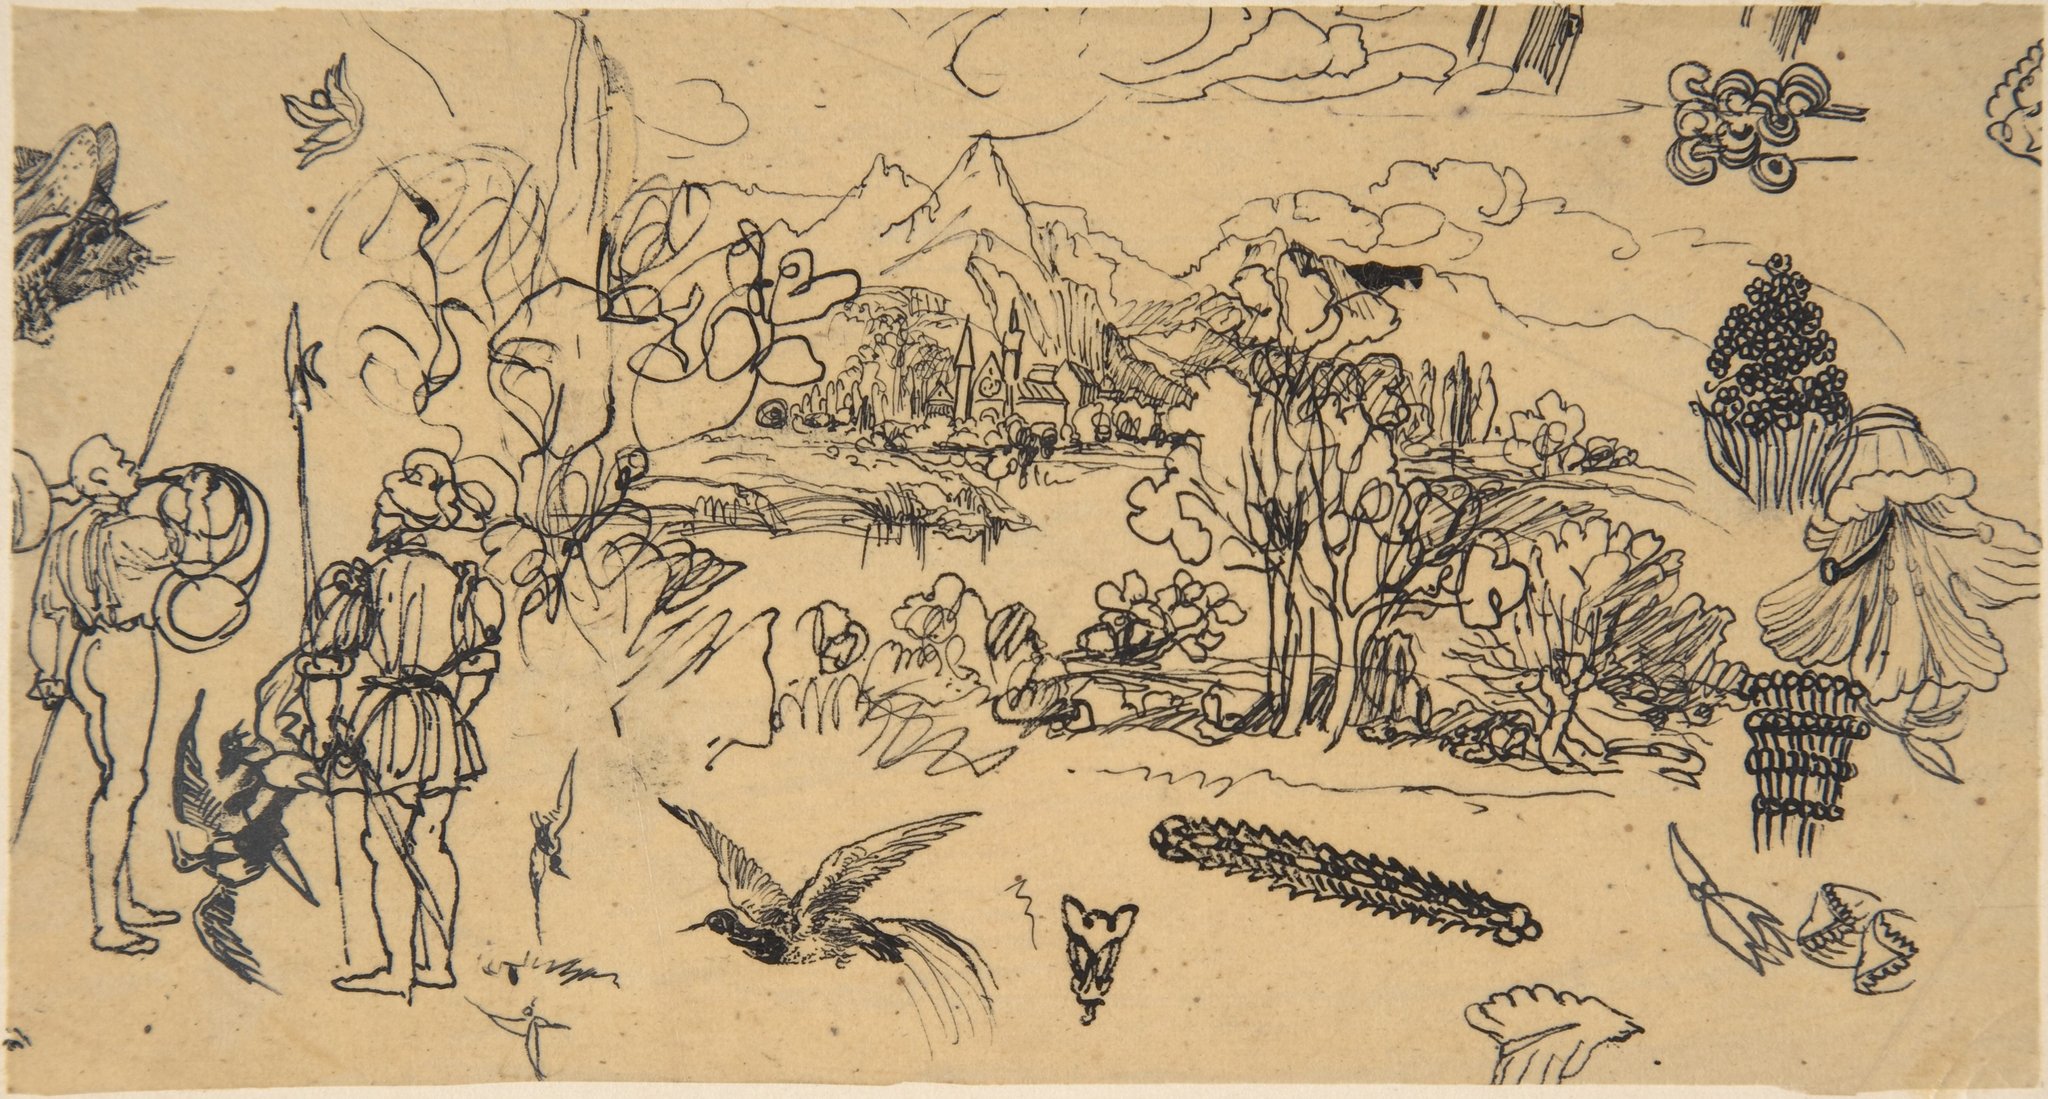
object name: drawing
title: Studies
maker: rodolphe bresdin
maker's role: artist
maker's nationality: french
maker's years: 1822-1885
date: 1822-1885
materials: ink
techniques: pen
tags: birds,soldiers